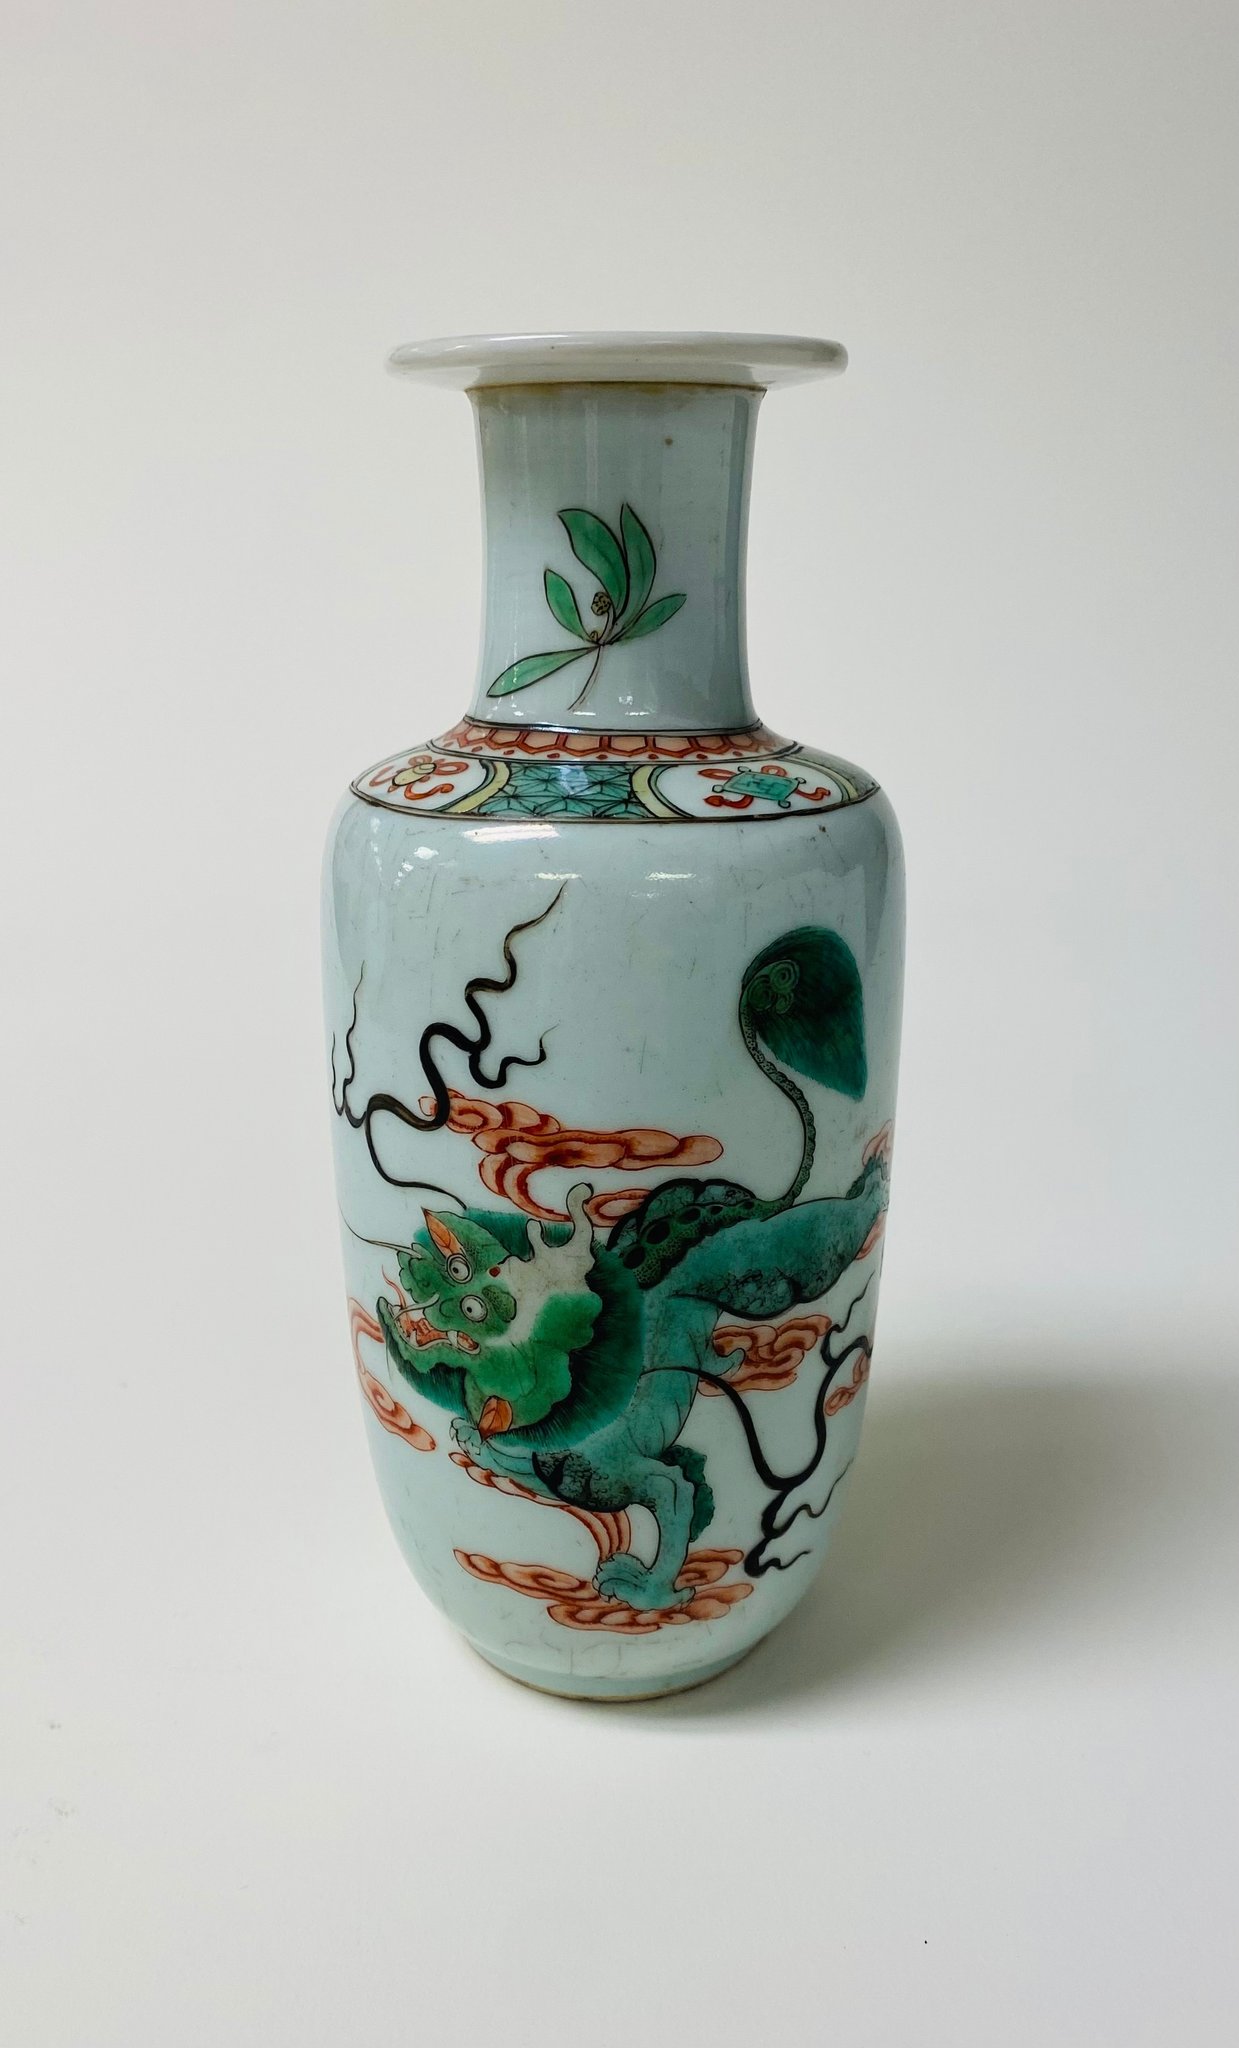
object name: vase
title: Vase with mythical creature qilin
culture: chinese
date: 1801-1900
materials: enamel, porcelain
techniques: overglaze, painting, polychrome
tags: mythical creatures